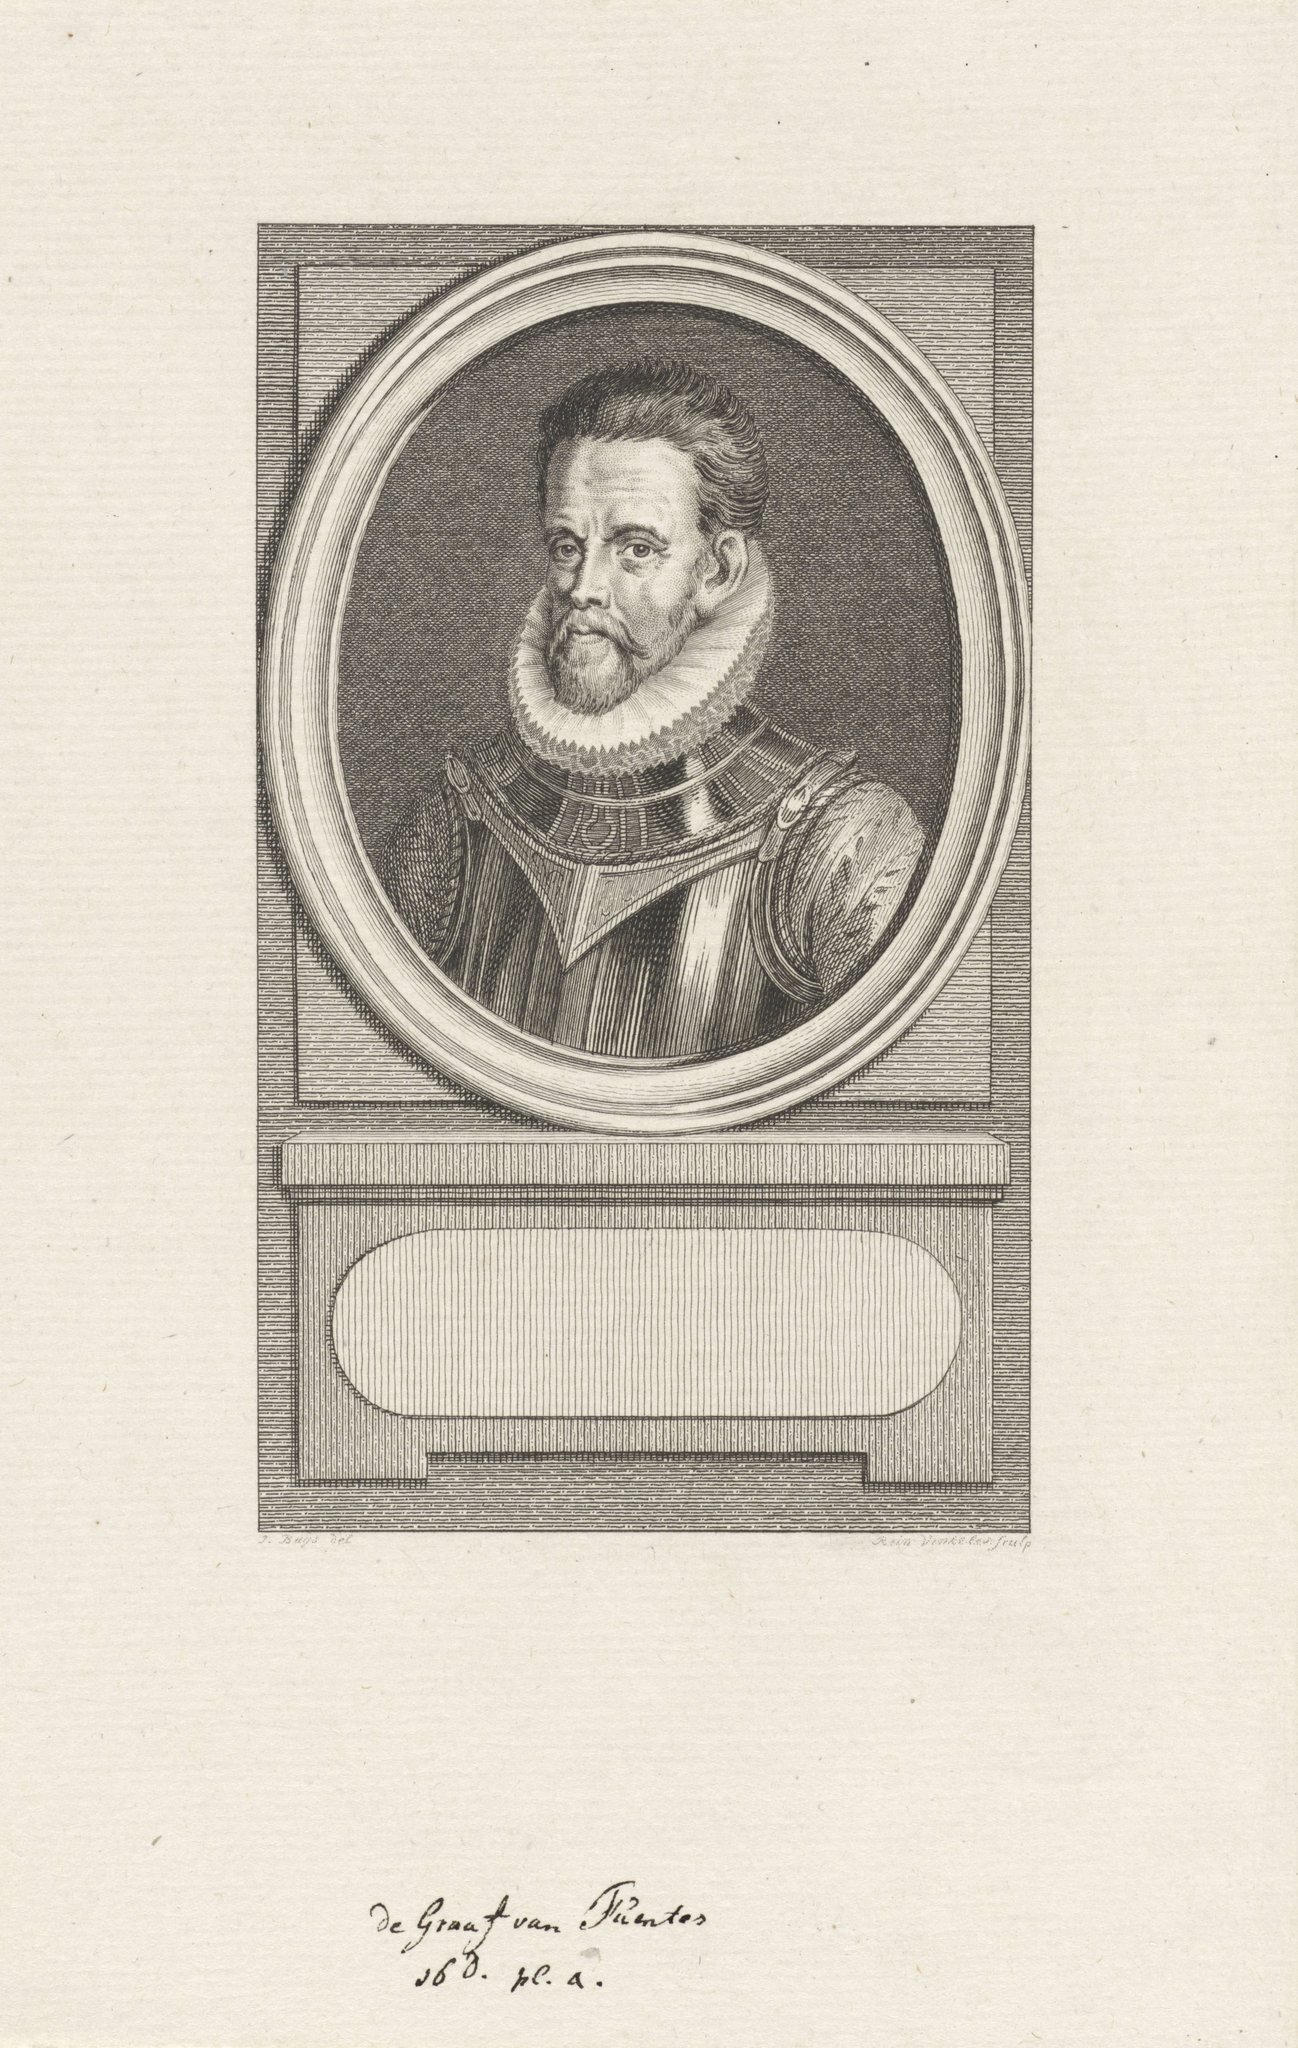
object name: print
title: Portret van Pedro Enríquez de Toledo de Acevedo, graaf van Fuentes de Valdepero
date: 1788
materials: paper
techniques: engraving, etching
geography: amsterdam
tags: politician, pedro enríquez de acevedo (count of fuentes)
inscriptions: caption: ‘de Graaf van Fuentes 16 D. pl. 4’, collector's mark: Lugt 240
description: Latere staat prent gebruikt als boekillustratie in: Kok, Jacobus. Vaderlandsch woordenboek : met kaarten, plaaten en pourtraitten. Amsterdam: Johannes Allart, 1785-1796. Deel XVI.